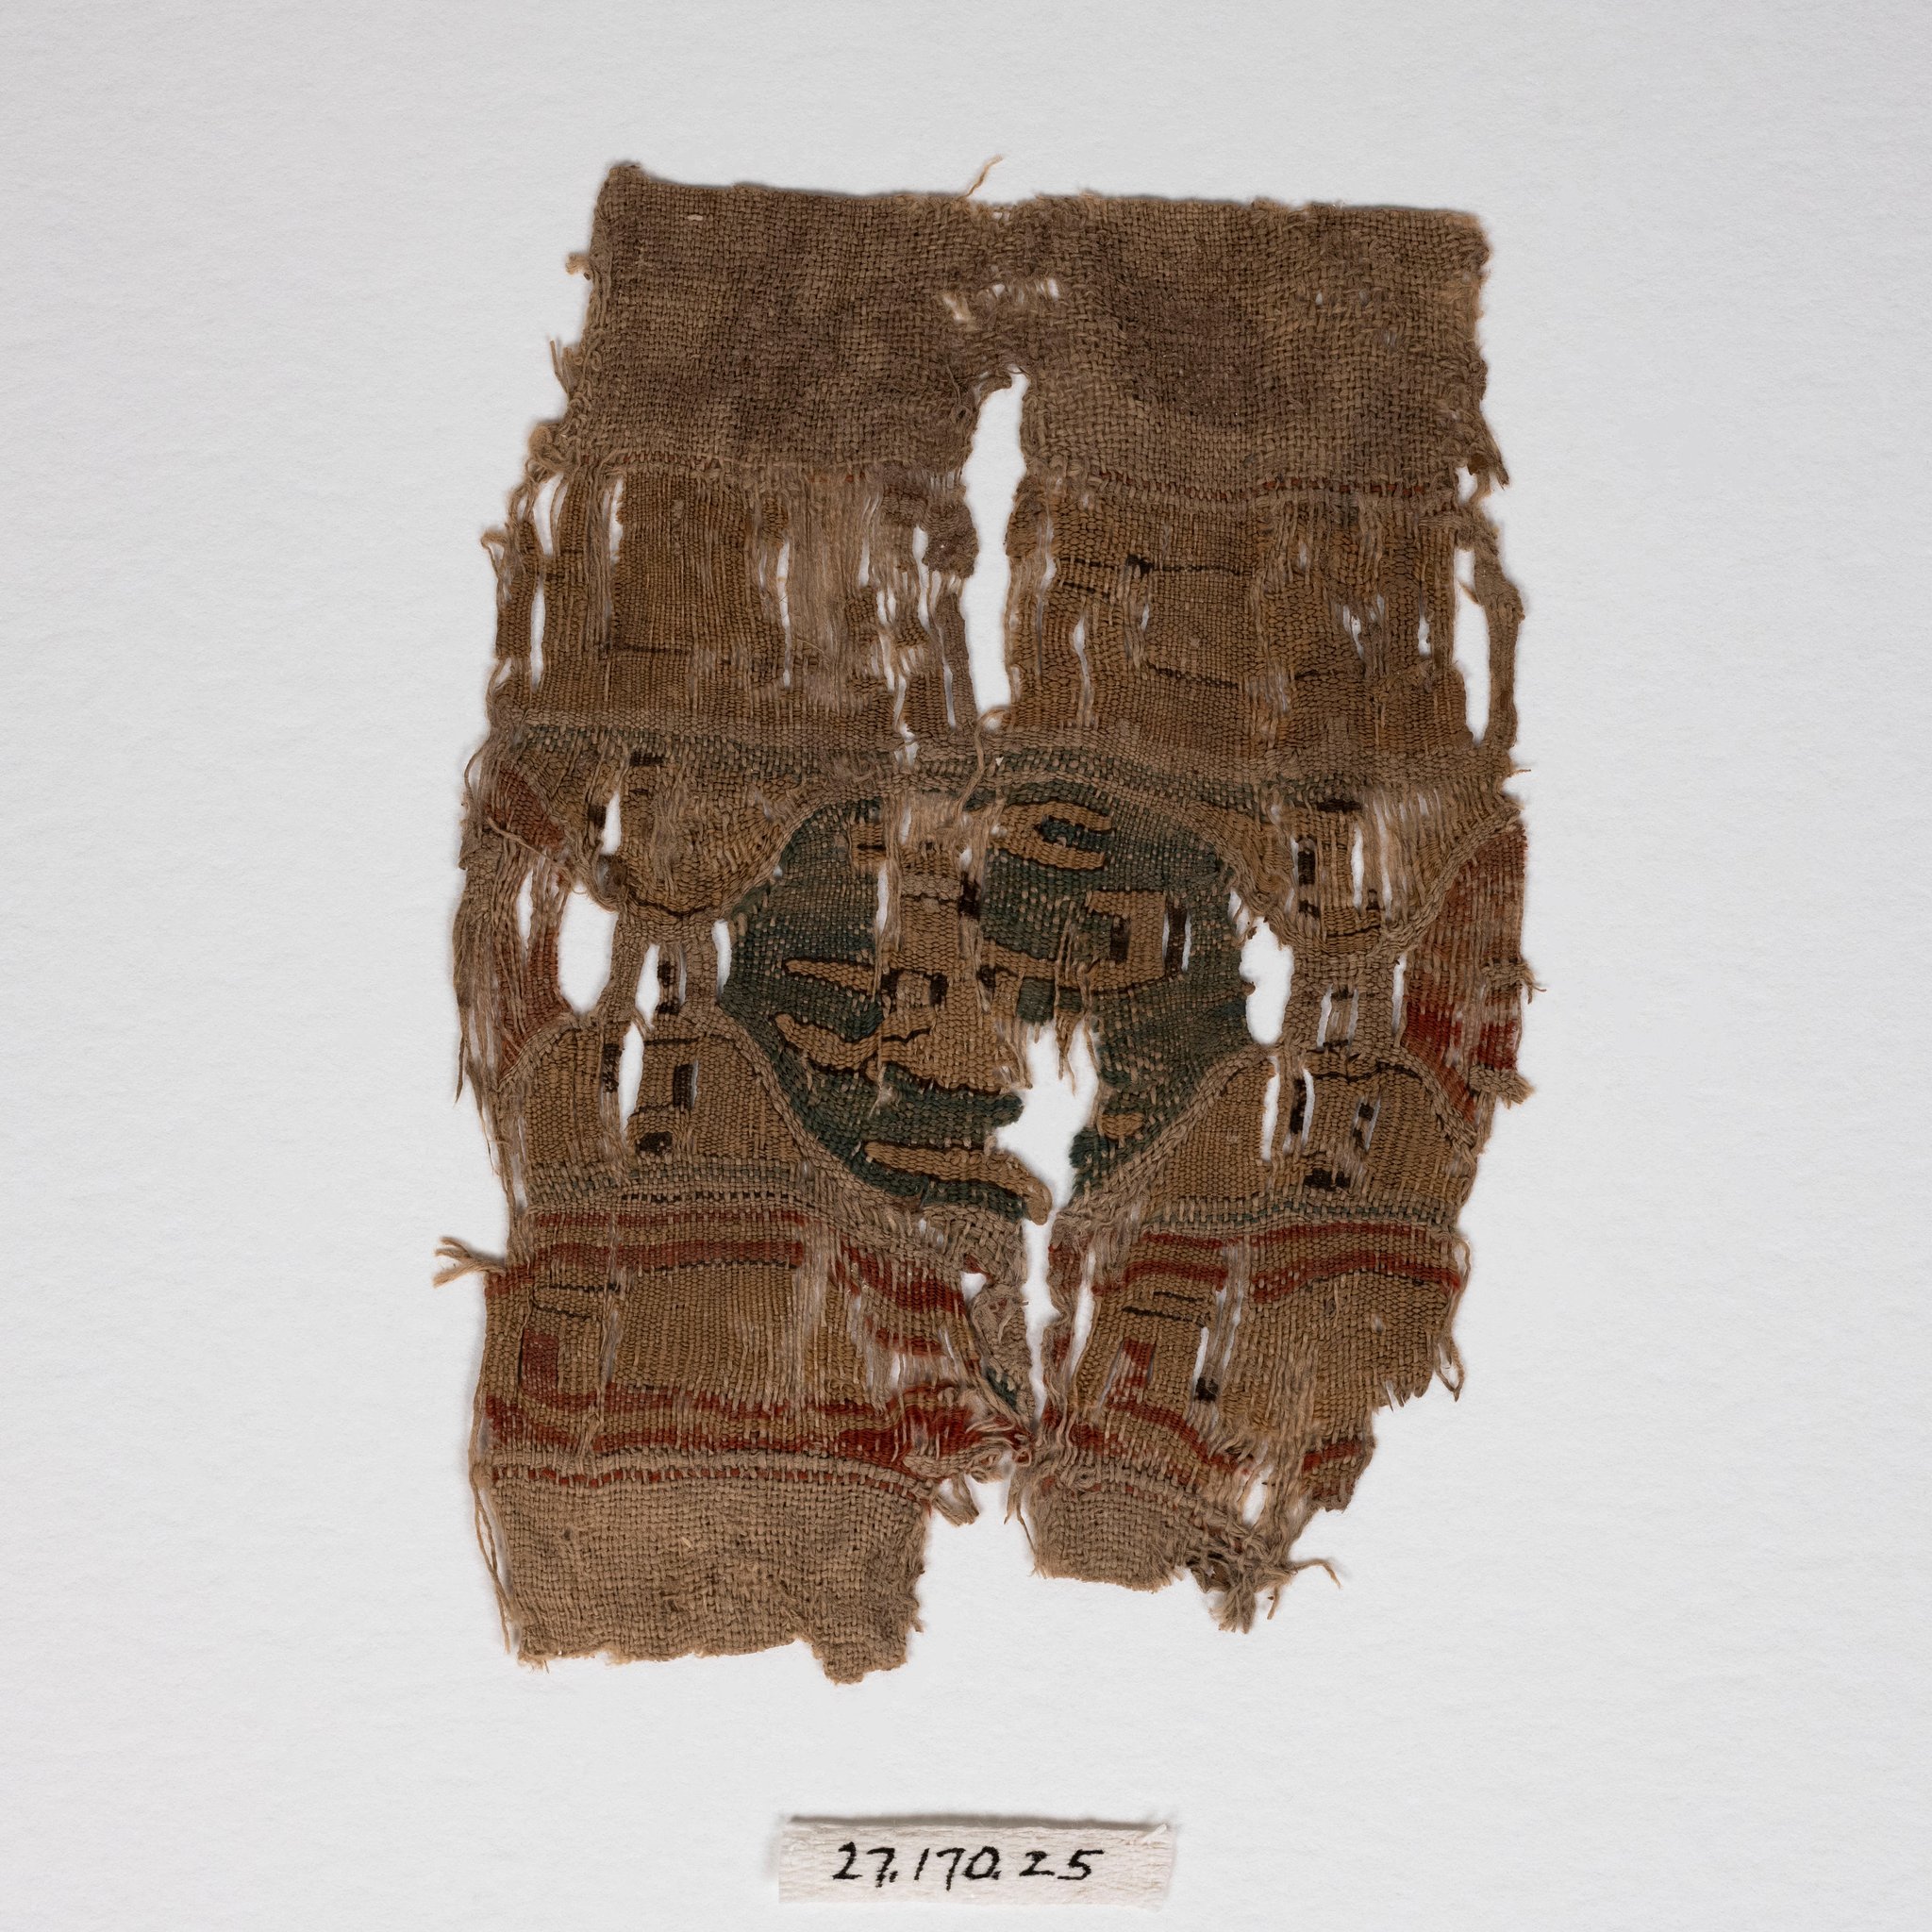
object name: textile fragment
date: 1034-1066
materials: cotton, silk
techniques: tapestry, weave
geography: egypt